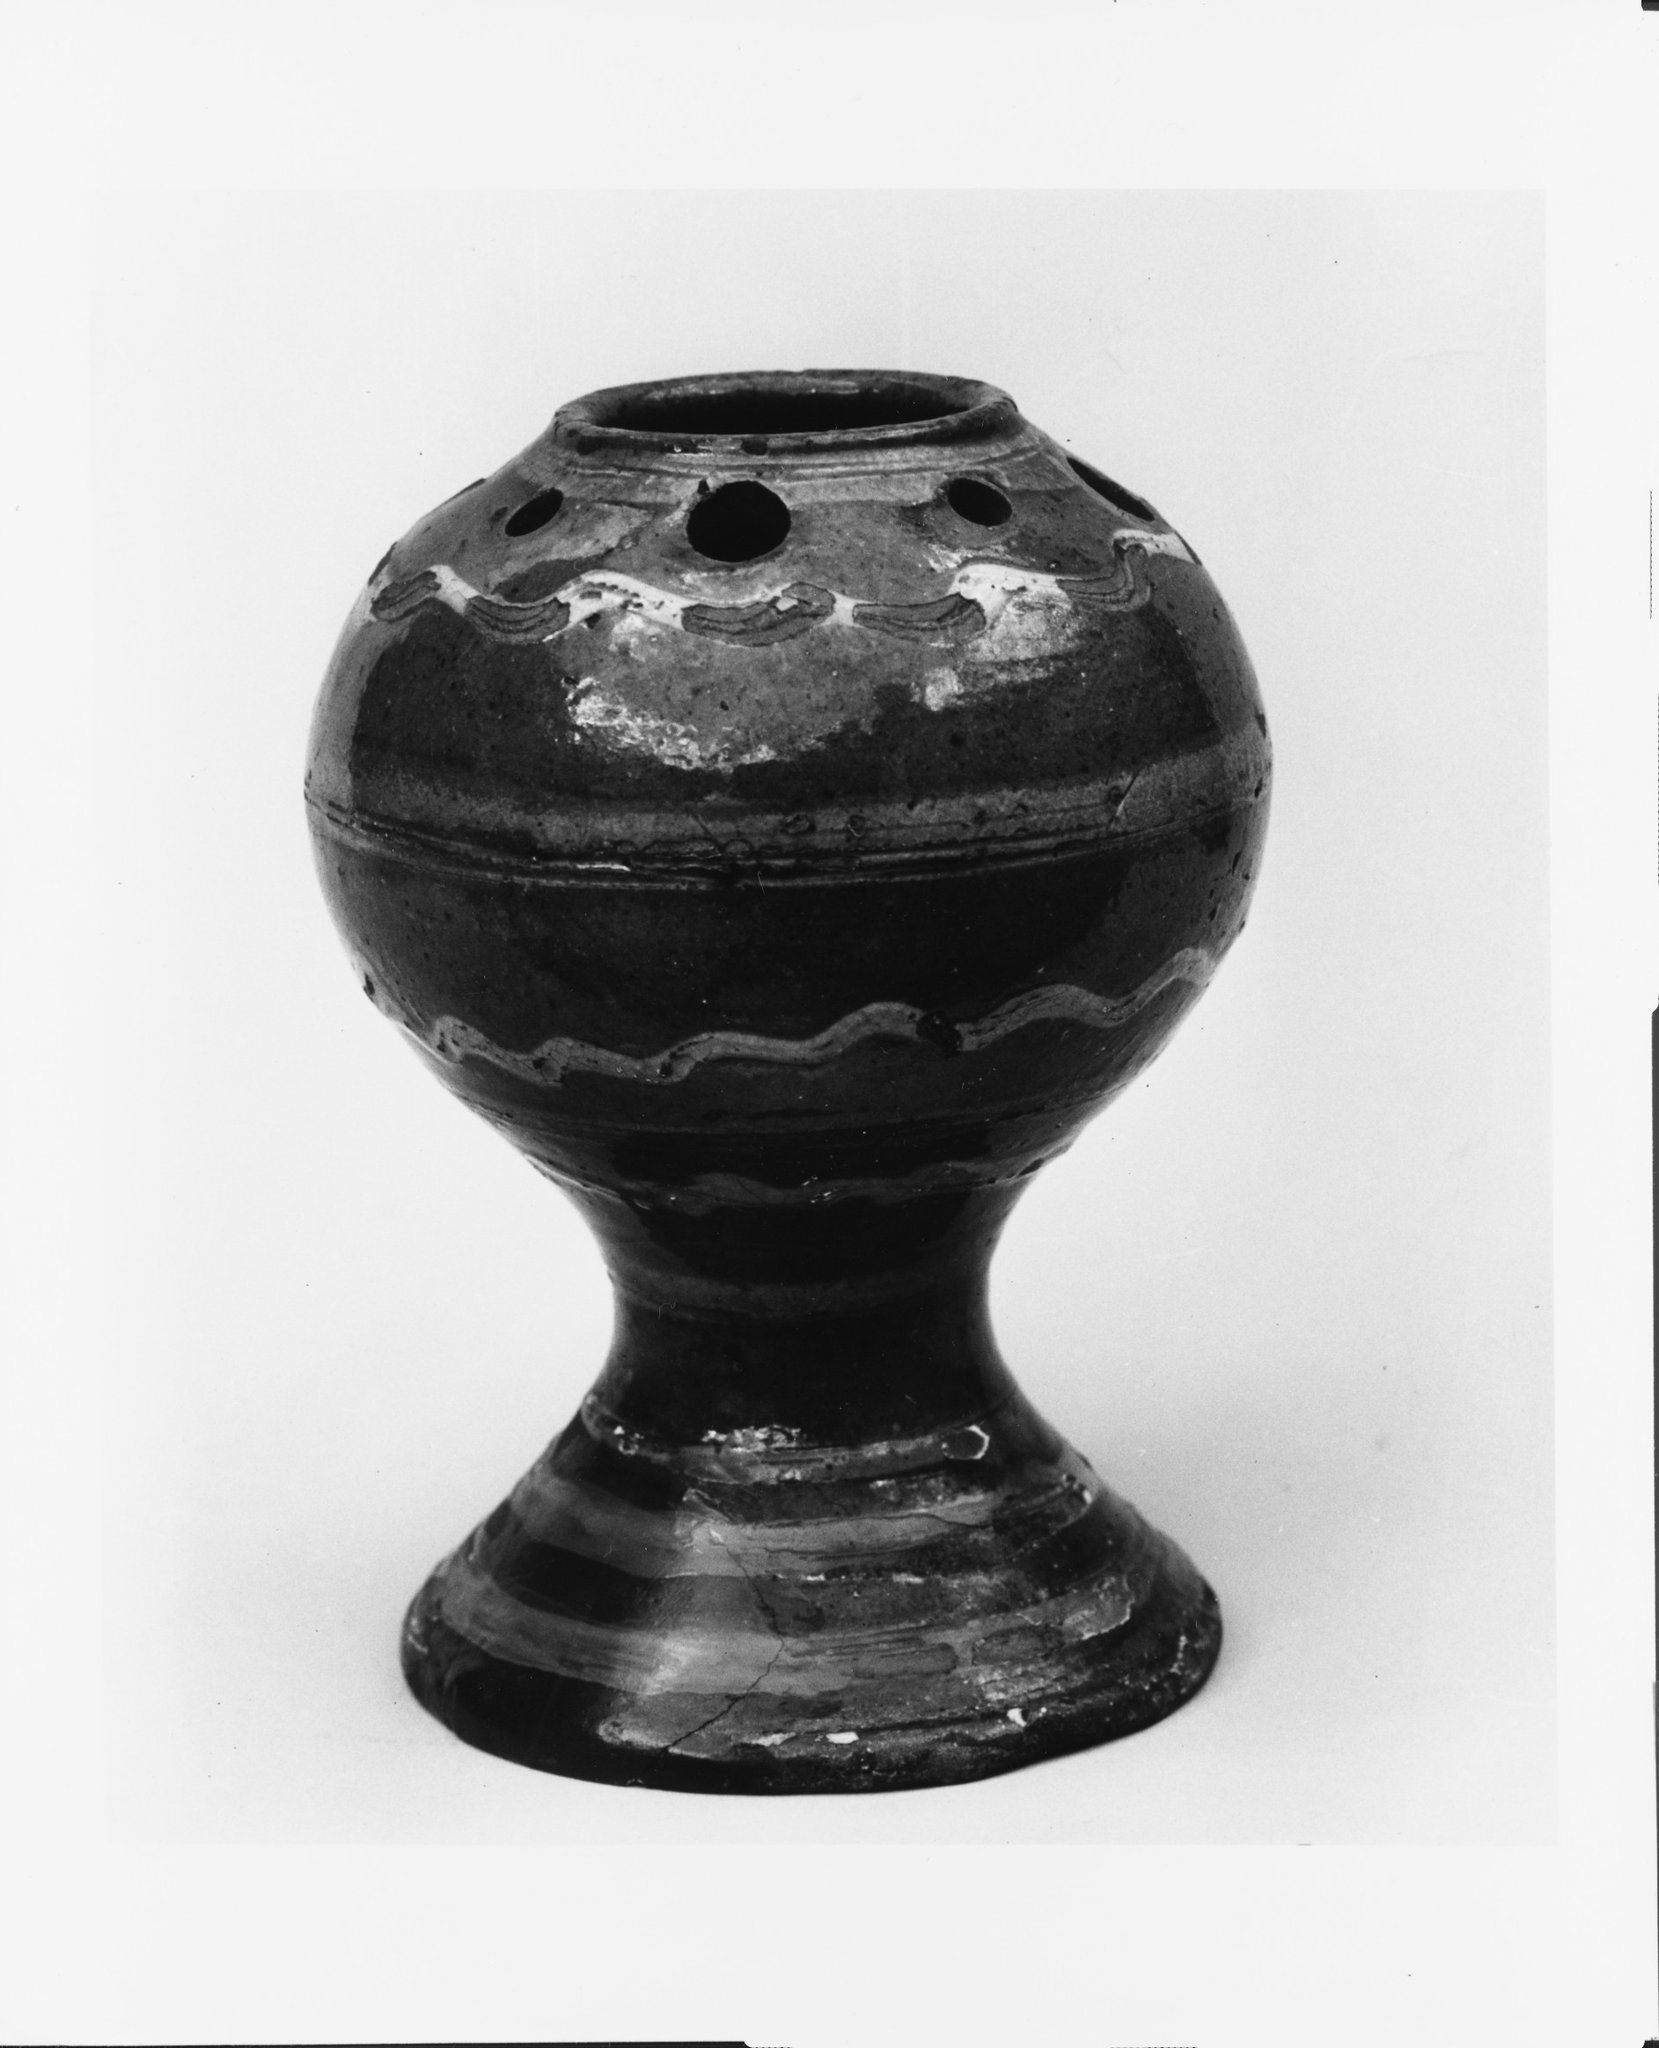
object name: flower holder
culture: american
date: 1700-1800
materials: earthenware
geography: united states